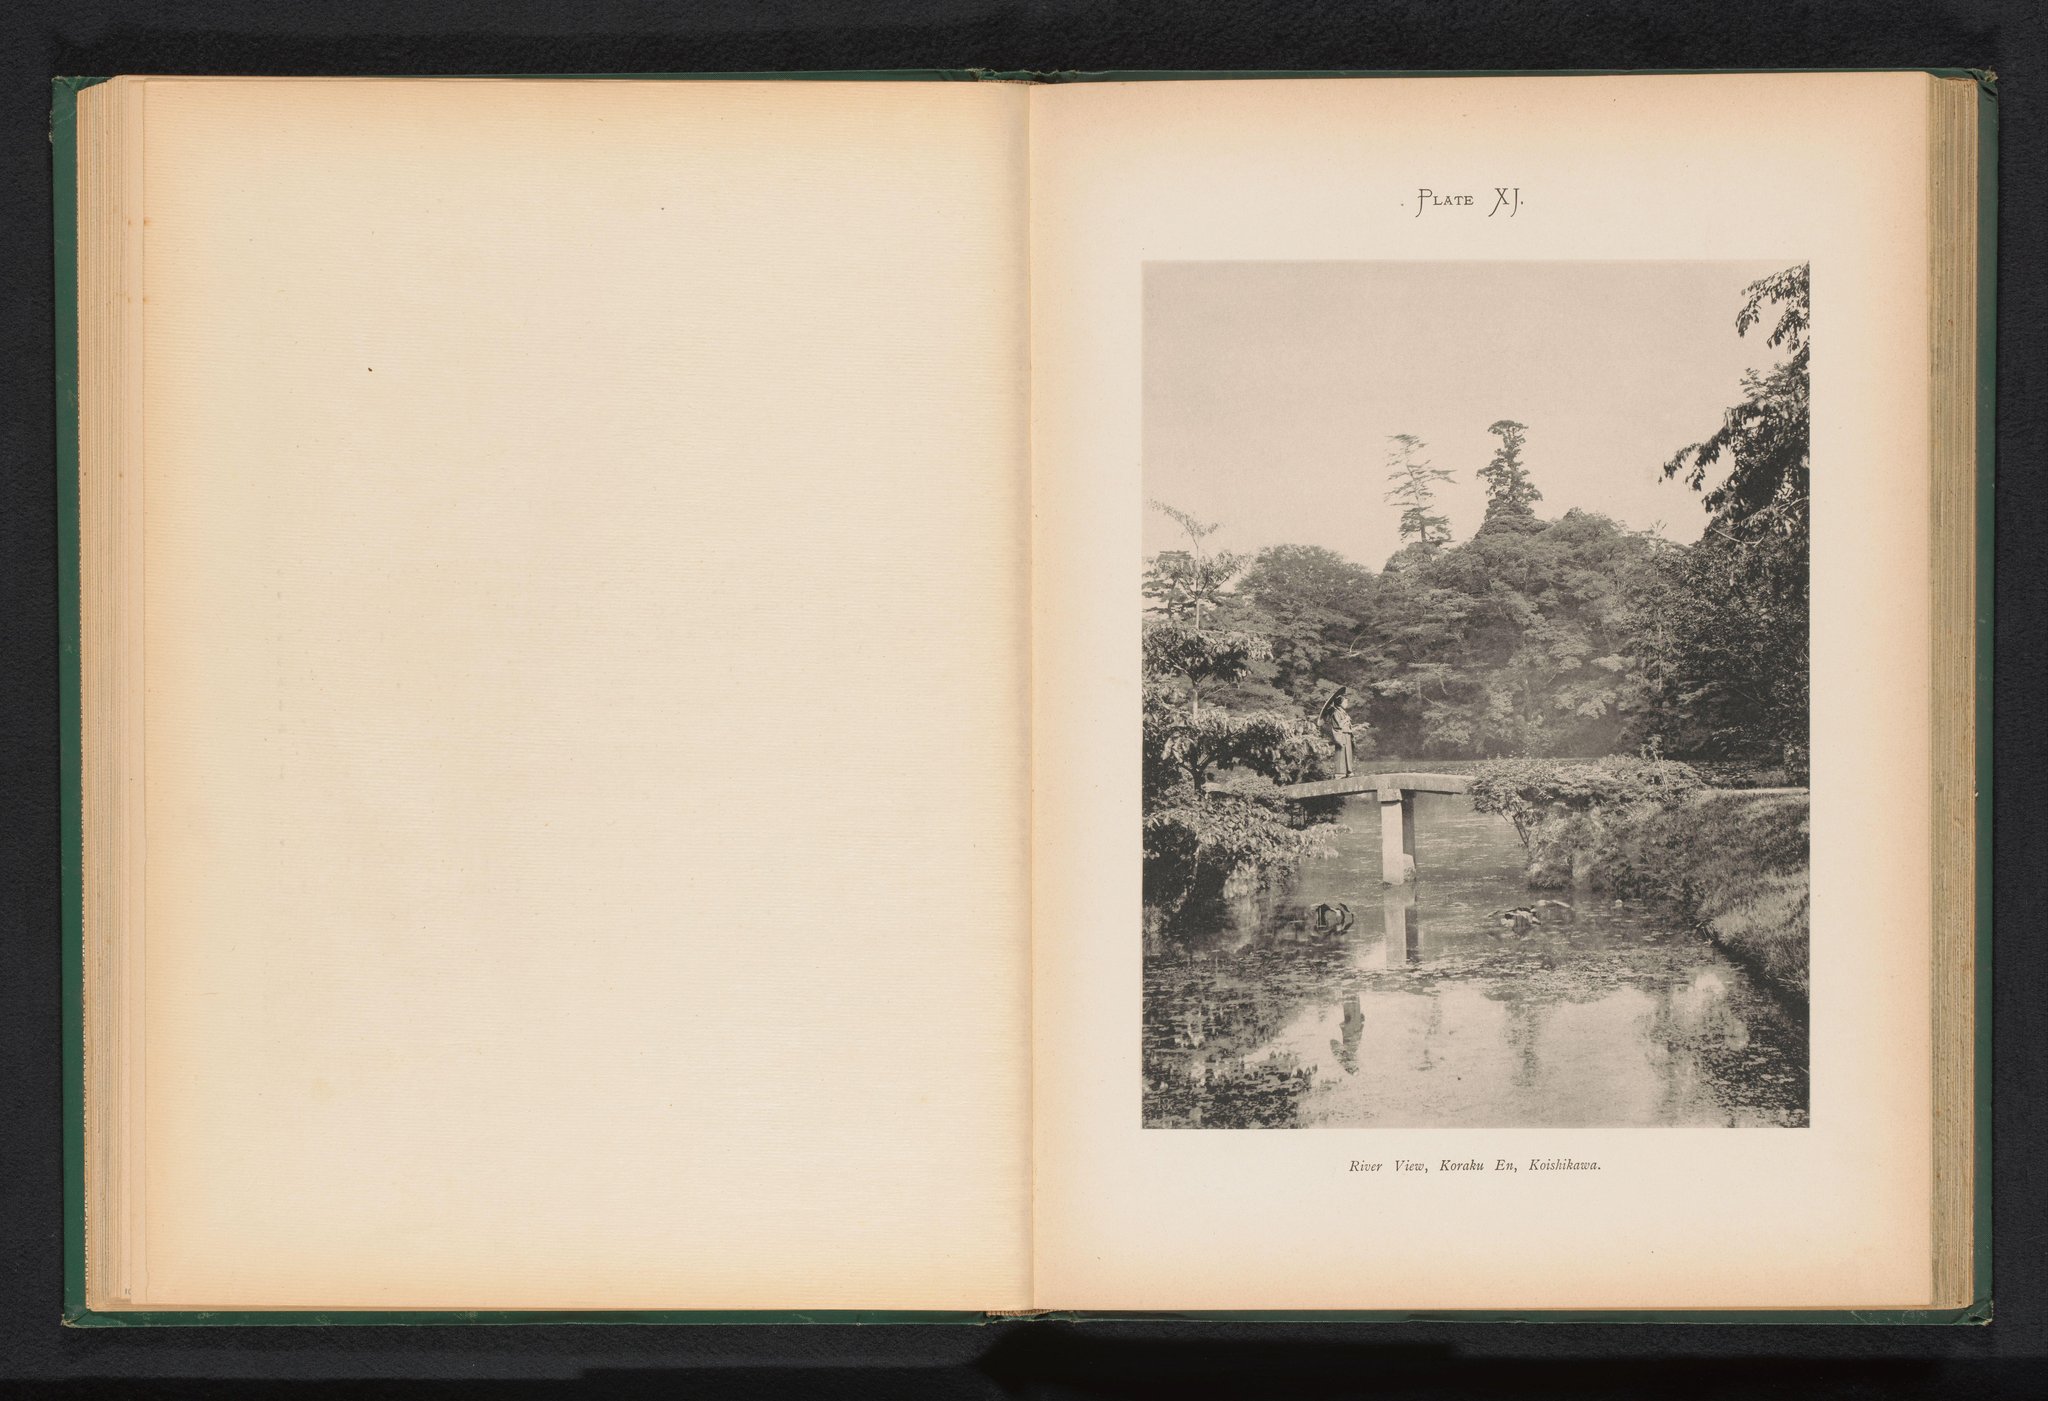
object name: page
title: Gezicht op de Koraku-en tuinen in Tokyo, Japan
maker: kazumasa ogawa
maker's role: auteur, fotograaf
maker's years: 1860-1929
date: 1888-1893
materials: paper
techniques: photograph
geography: tokyo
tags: garden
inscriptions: inscription: ‘Plate XI.’